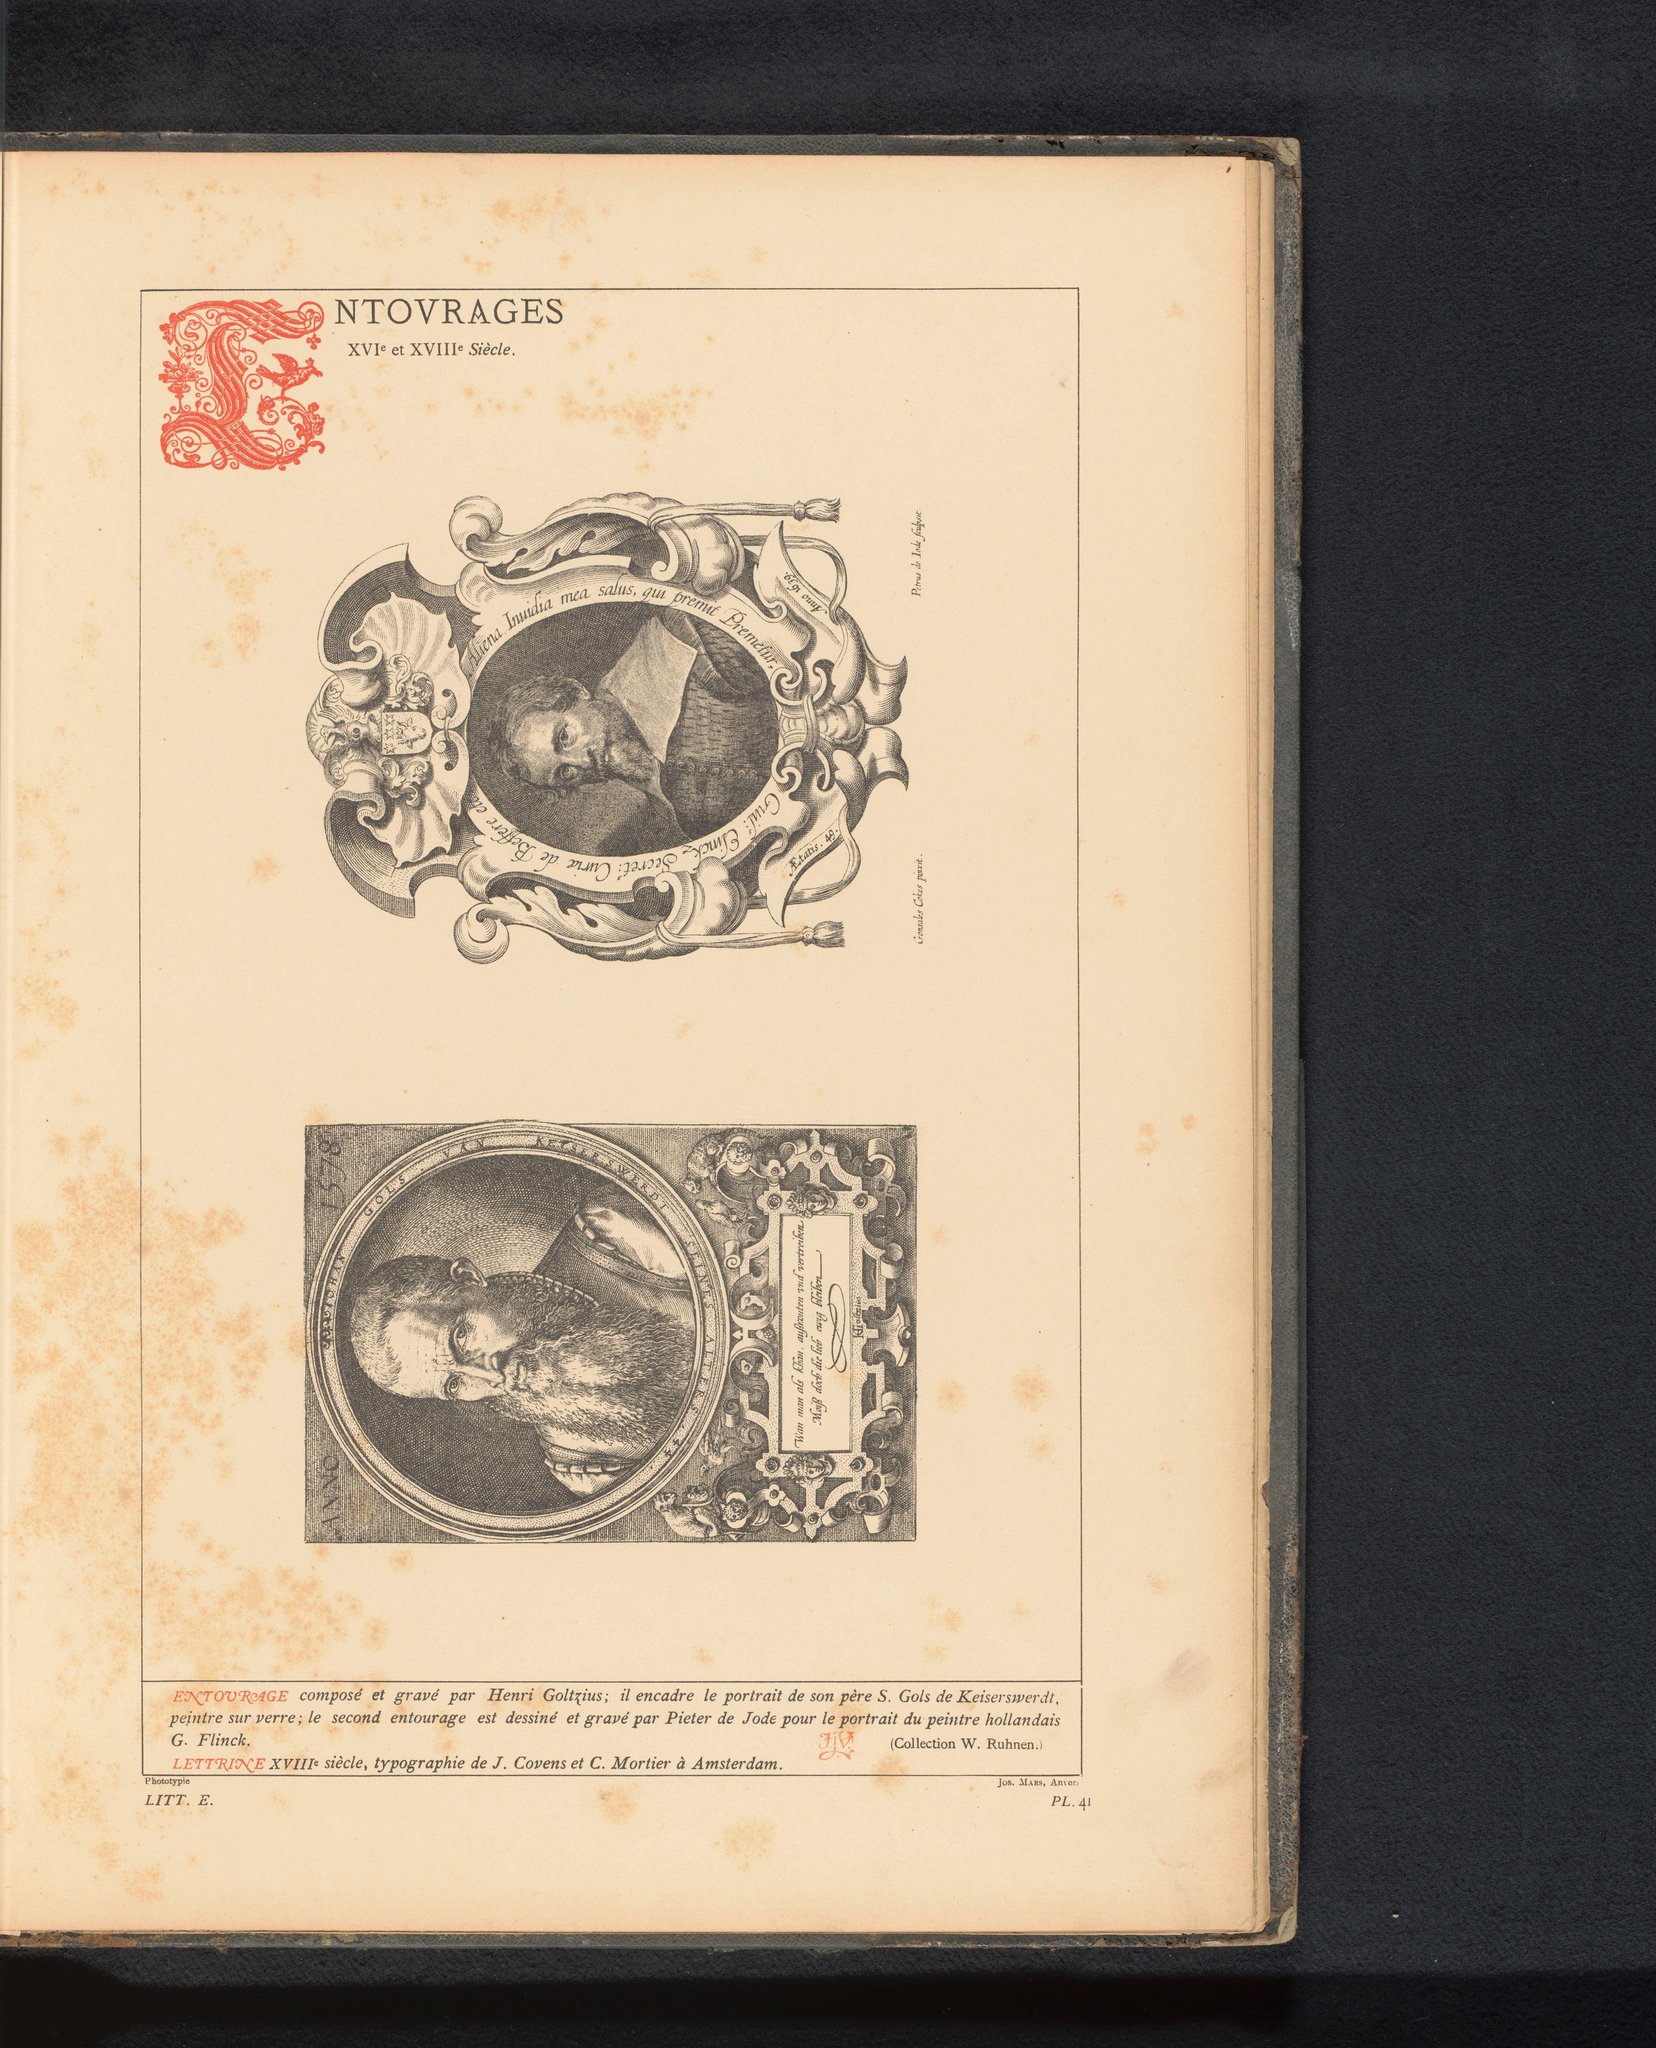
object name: photomechanical print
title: Reproductie van een prent van een portret van Jan Goltz II door Hendrick Goltzius en een prent van een portret van Govert Flinck door Pieter de Jode I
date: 1875-1880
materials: paper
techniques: photolithography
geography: amsterdam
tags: cleves, amsterdam, draughtsman, govert flinck, historical persons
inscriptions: monogram: ‘JJvY’, inscription: ‘LITT. E. - PL. 41’, inscription: ‘ENTOURAGES composé et gravé (...)’